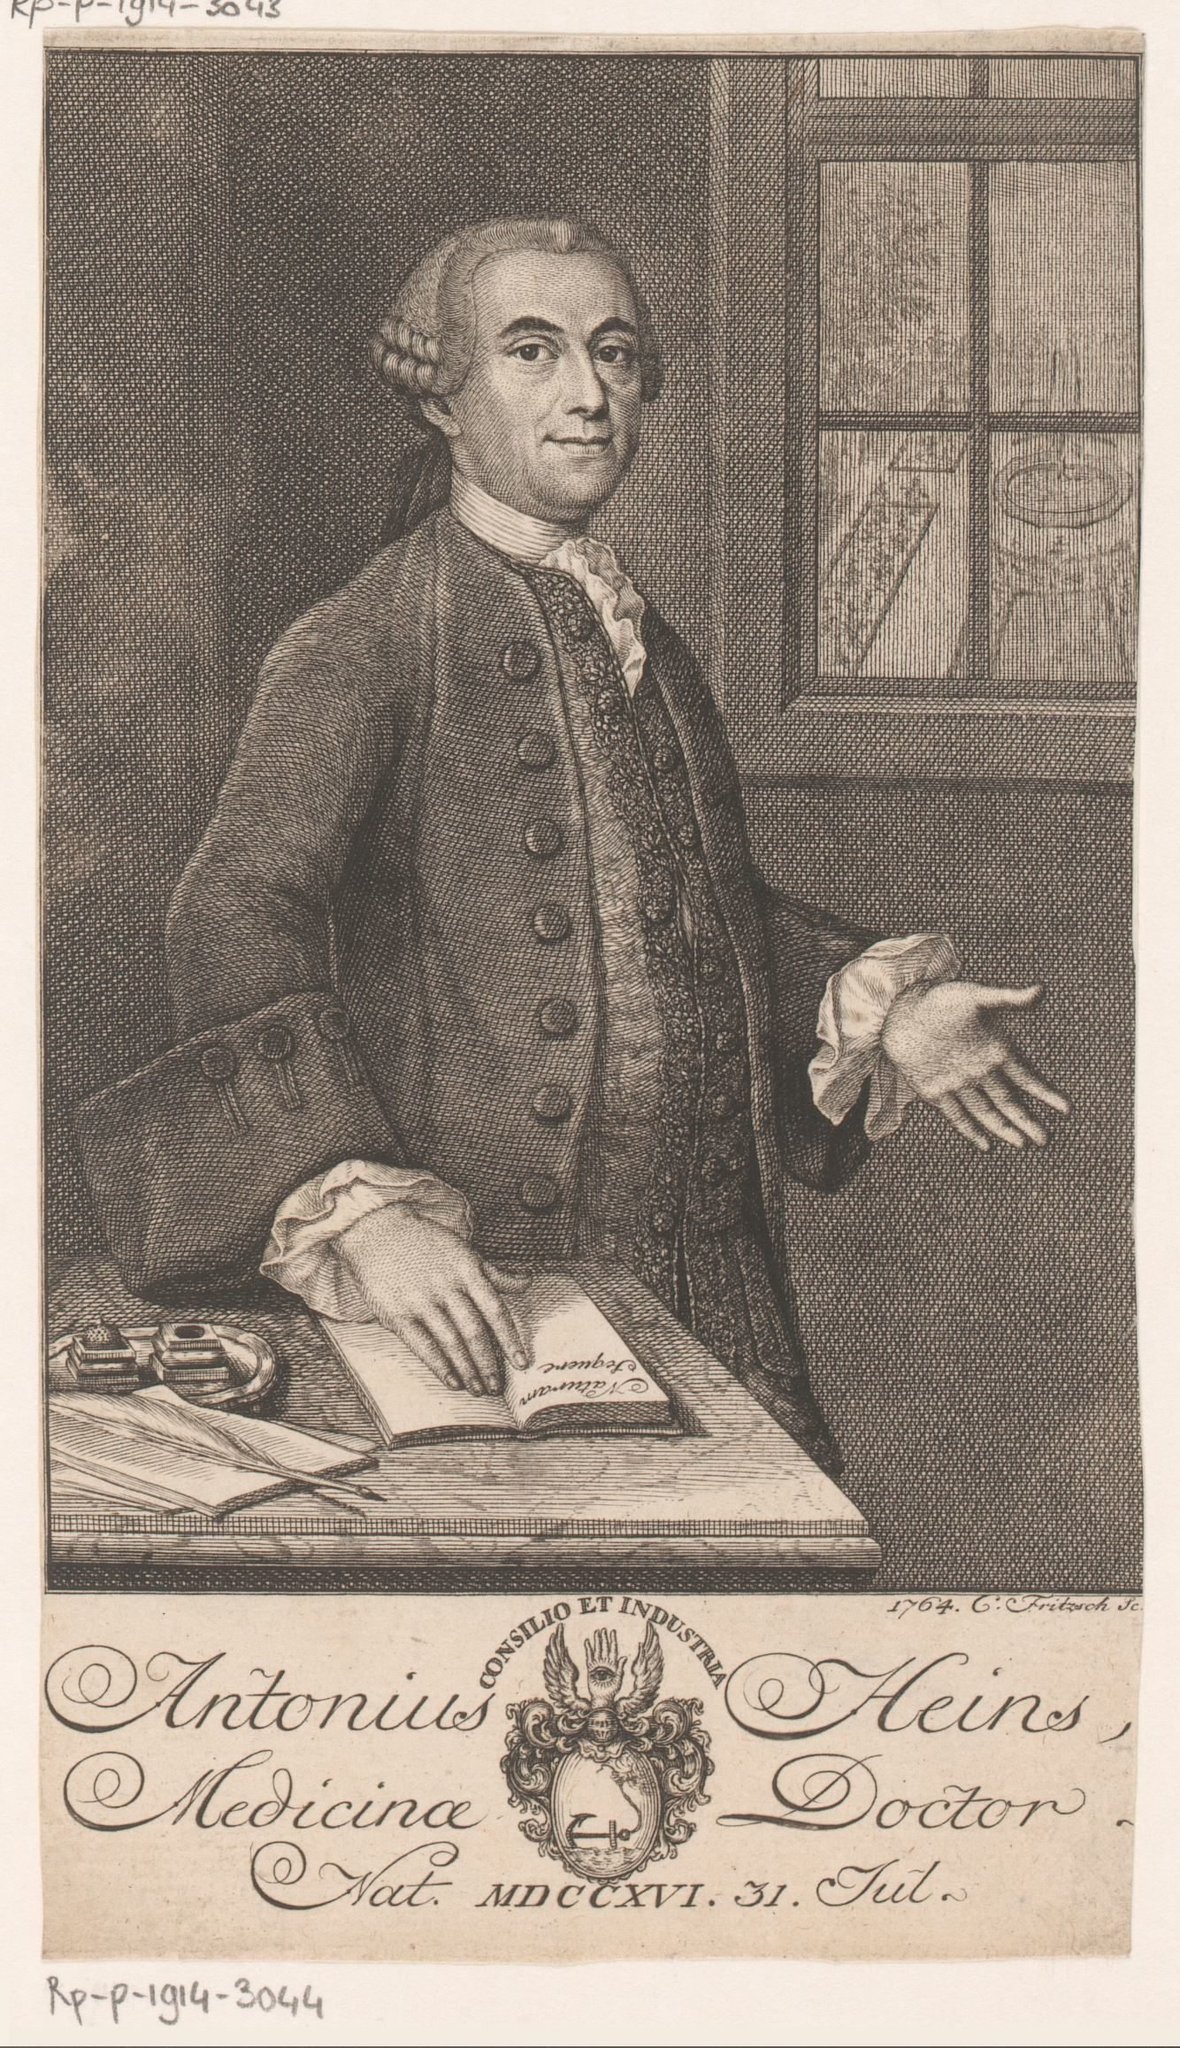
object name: print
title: Portret van Anton Heins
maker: christian fritzsch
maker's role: print maker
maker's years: 1695-1769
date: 1764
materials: paper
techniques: engraving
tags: writing tools, garden, historical persons, book, armorial bearing, heraldry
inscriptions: collector's mark: Lugt 2228